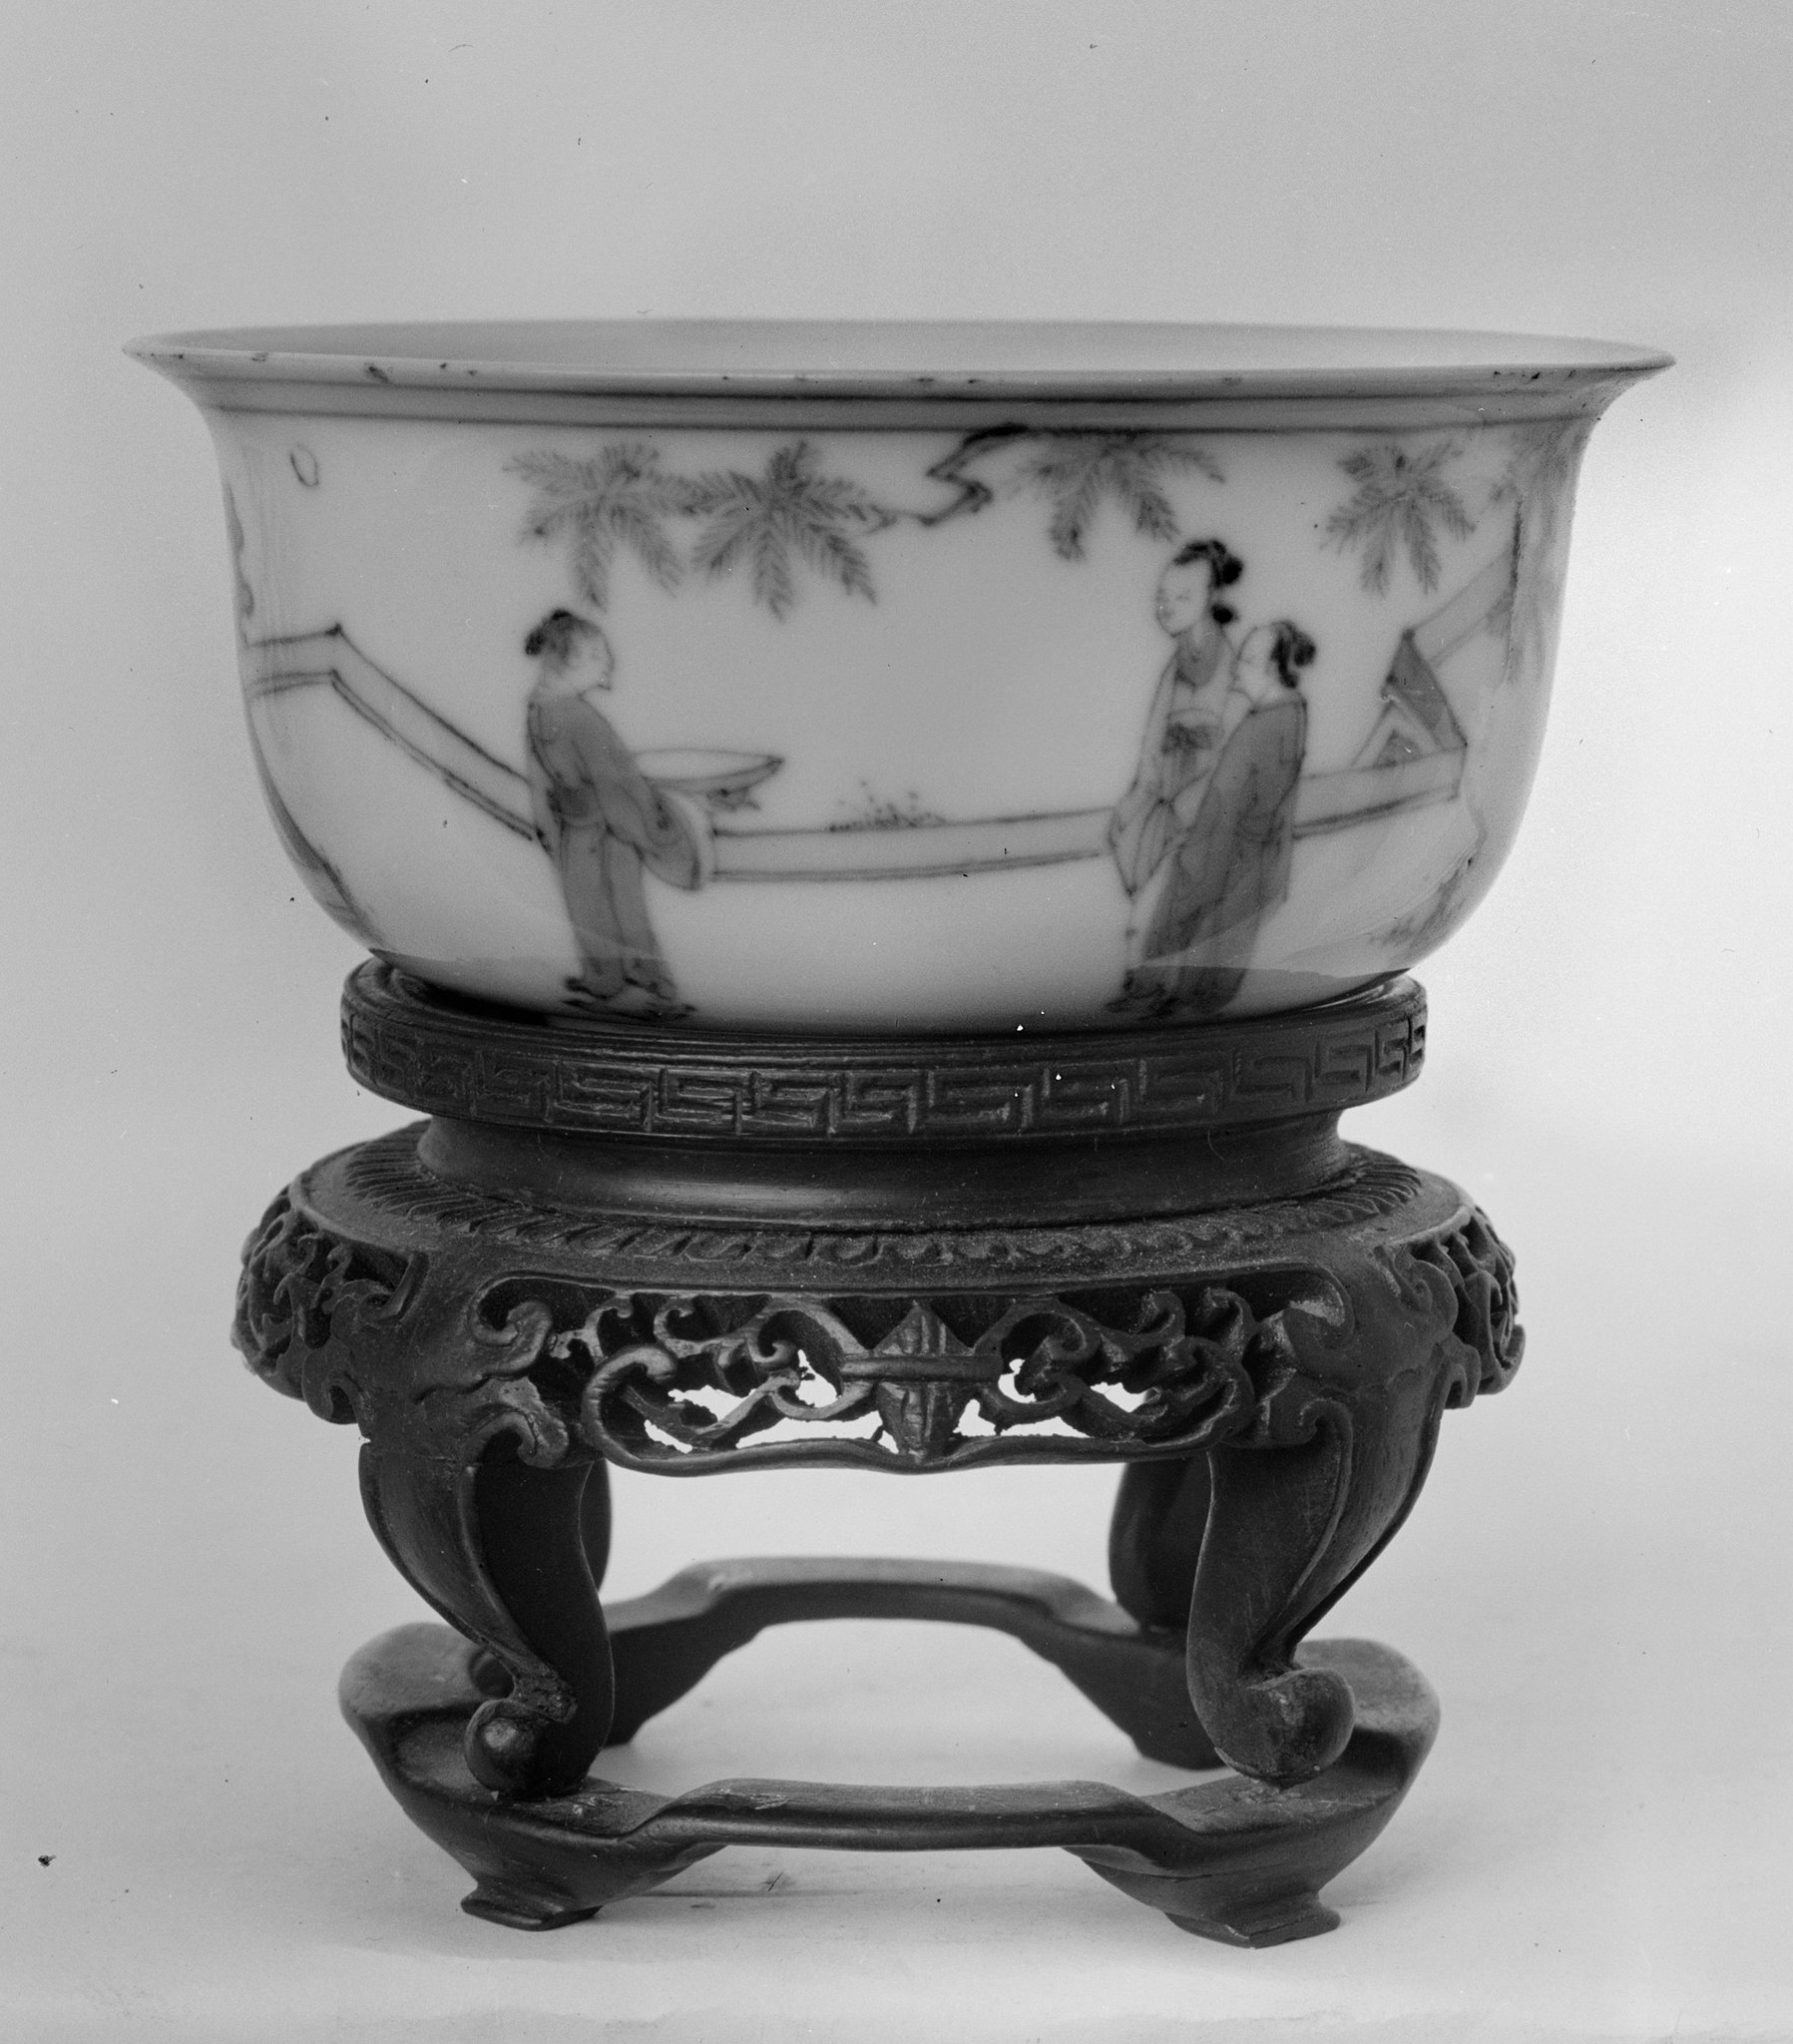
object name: cup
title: Cup with figures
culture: chinese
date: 1634-1666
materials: cobalt, porcelain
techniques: painting, underglaze